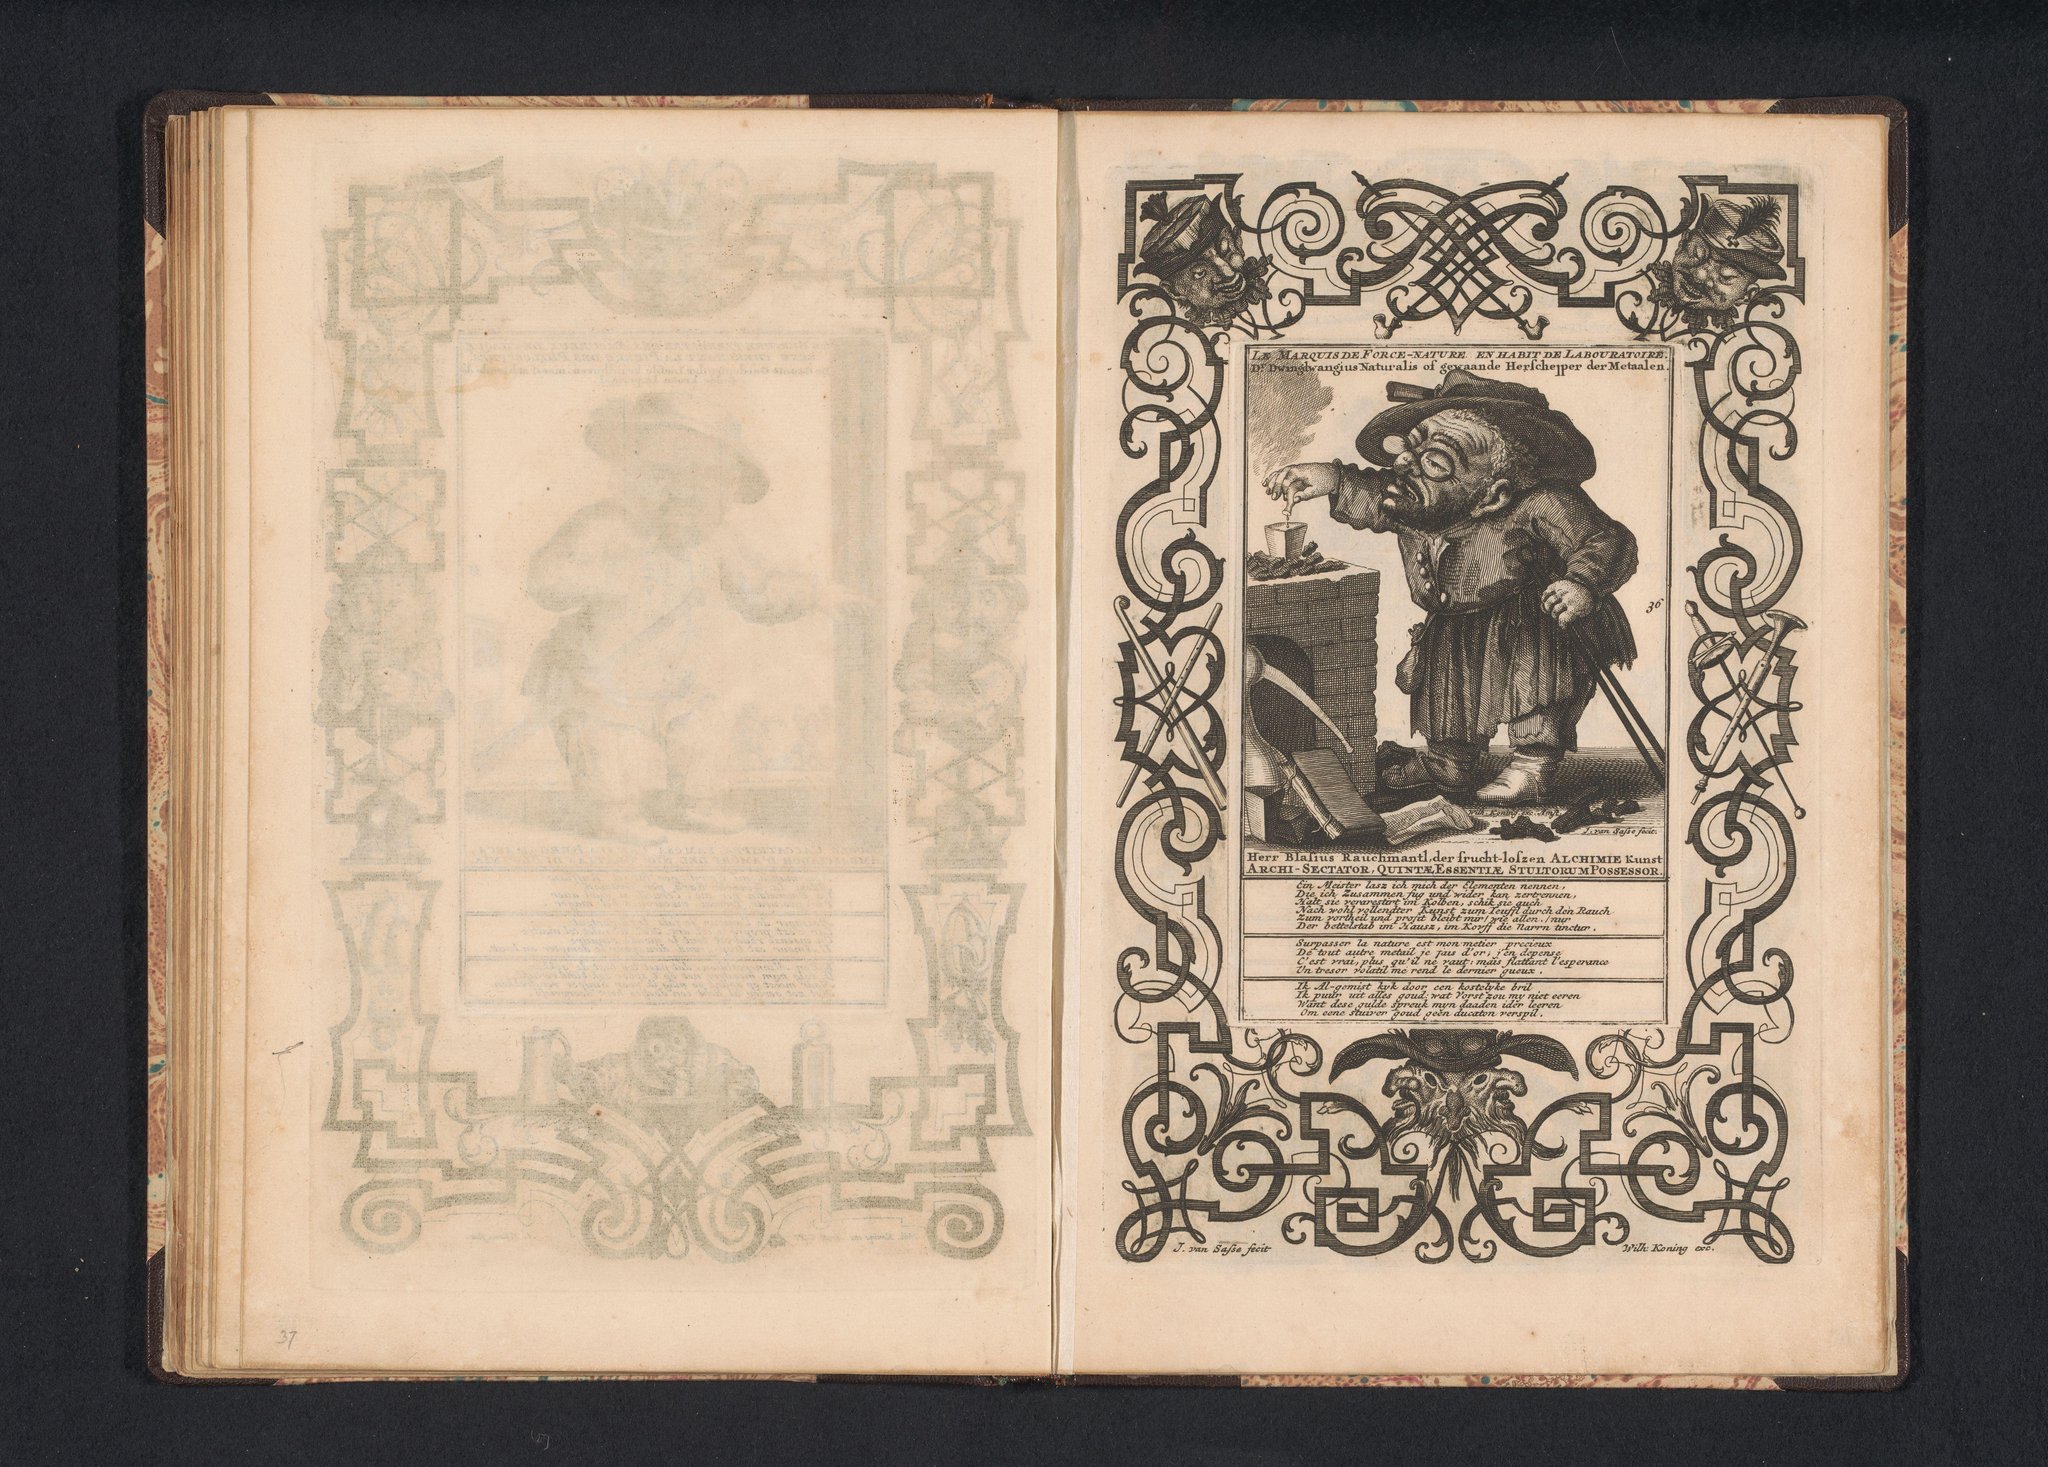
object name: print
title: Le Marquis de Force-Nature en habit de labouratoire / Dr. Dwingdwangius Naturalis of gewaande Herschepper der Metaalen / Herr Blasius Rauchmantl, der frucht-loszen Alchimie Kunst Archi-Sectator, Quintae Essentiae Stultorum Possessor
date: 1716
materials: paper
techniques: etching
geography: amsterdam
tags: caricatures (human types), little people, alchemist at work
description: De kleine mens Dr. Dwingdwangius Naturalis als alchemist. In het onderschrift verzen in het Duits, Frans en Nederlands. Afdruk binnen een decoratieve omlijsting gedrukt van een aparte plaat met koppen van kleine mensen en maskers. Genummerd rechts midden: 36. Onderdeel van de Nederlandse gebonden uitgave uit 1716 van een serie karikaturen van kleine mensen, bekend als Het Dwergentooneel, gekopieerd naar een ouder Duits voorbeeld.